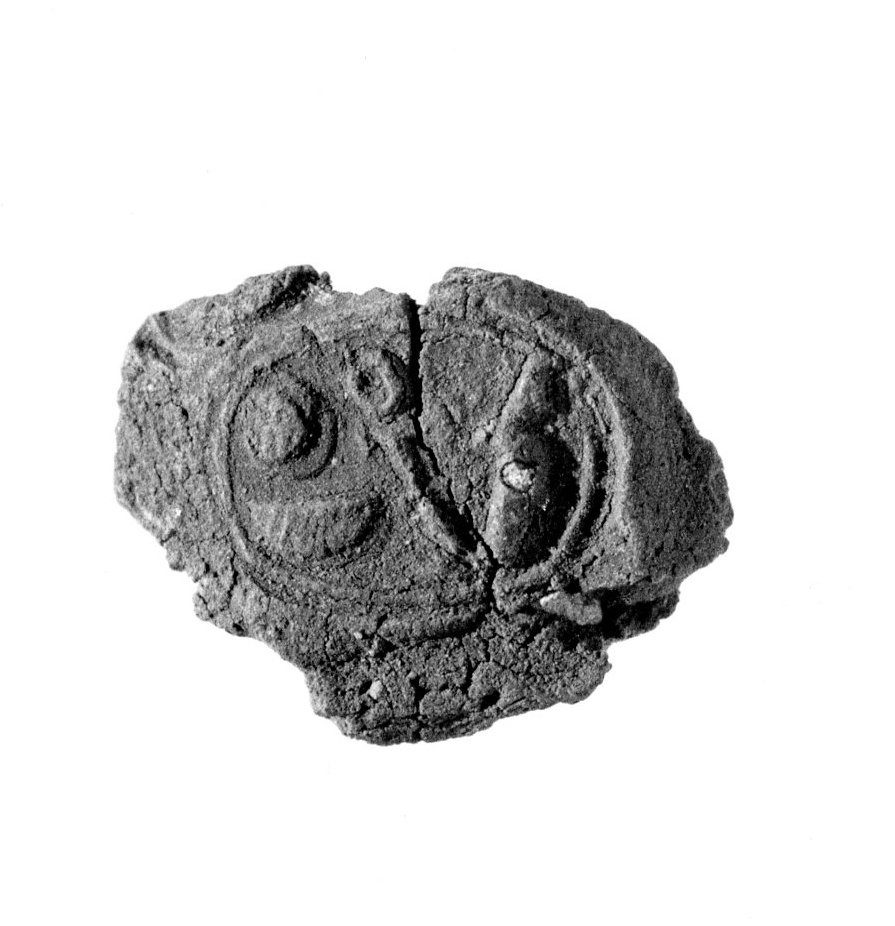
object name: sealing, nebmaatre, amenhotep iii,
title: Document Sealing with the Throne Name of Amenhotep III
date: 1390-1352 BCE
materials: mud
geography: egypt